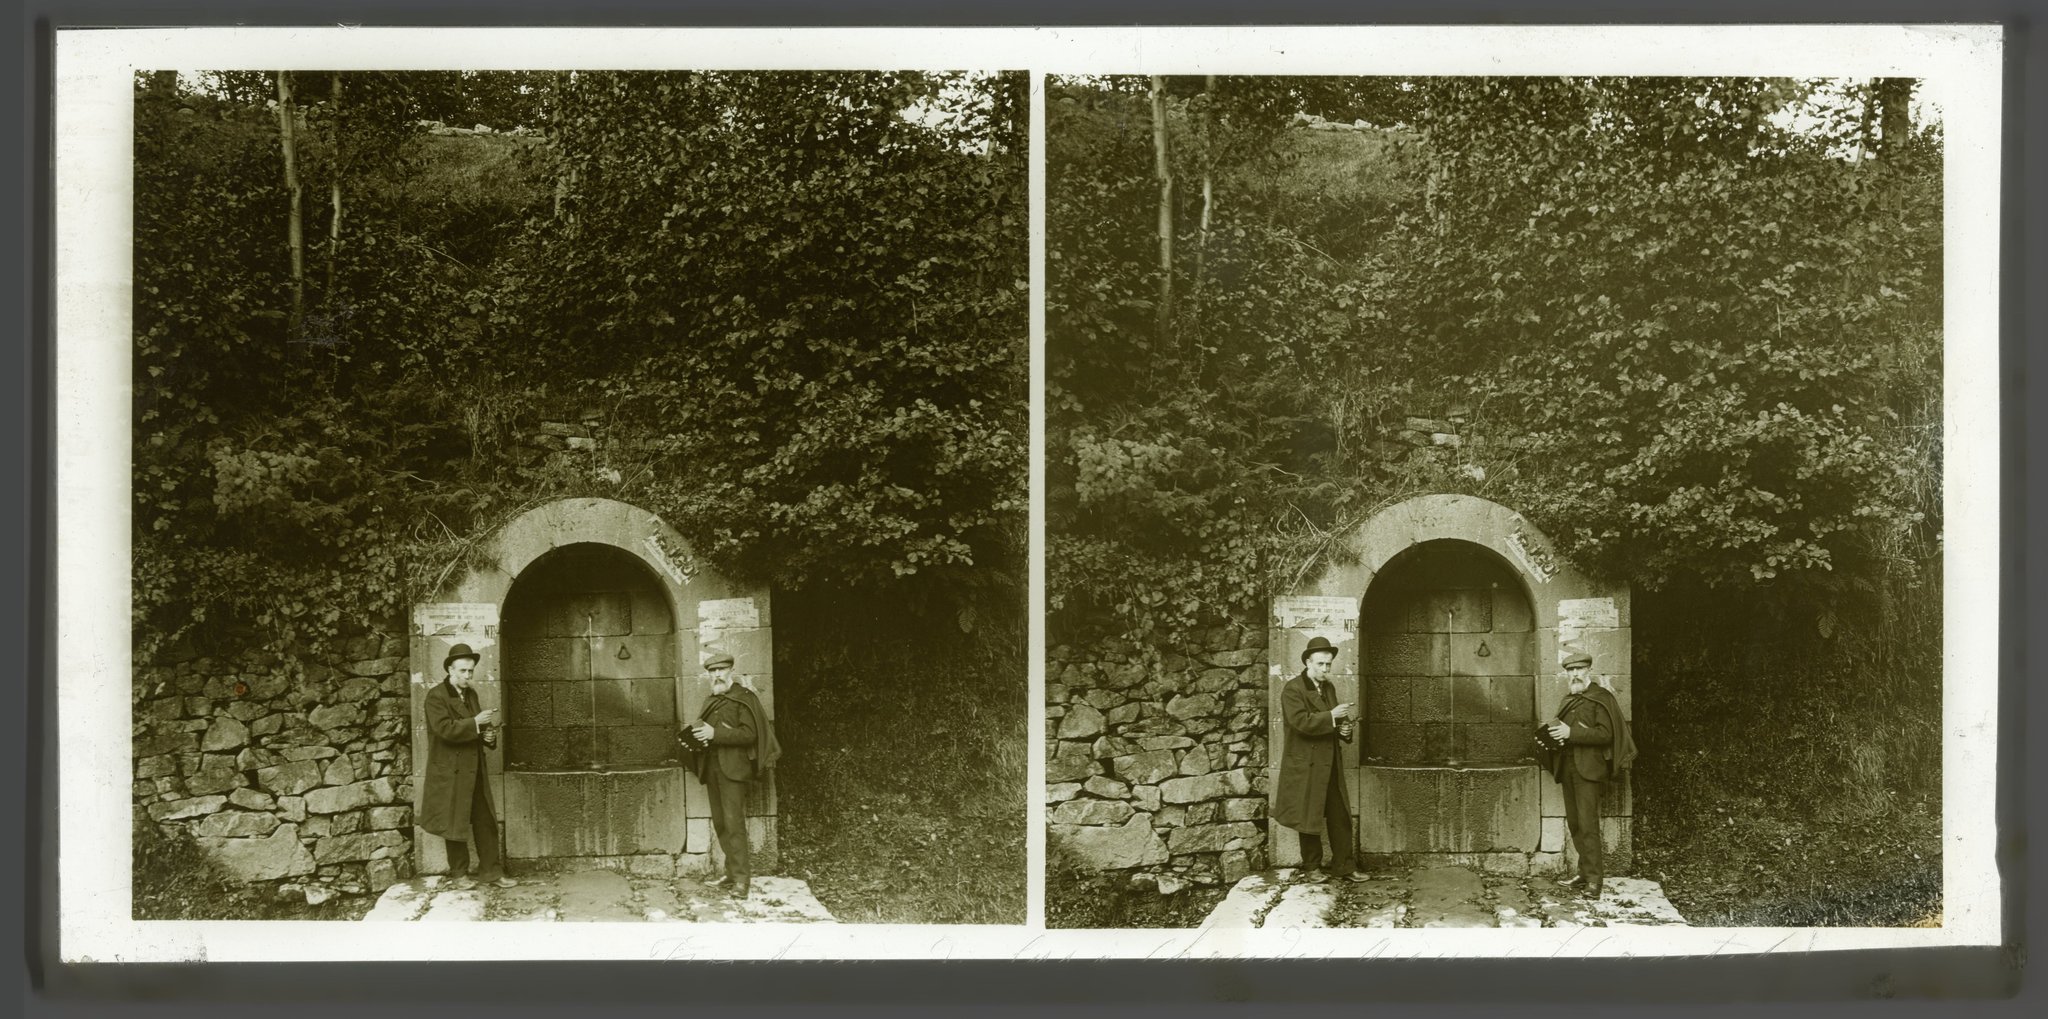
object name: stereoscopic photograph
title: Twee mannen staande voor een fontein in Chaudes-Aigues, Frankrijk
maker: Anonymous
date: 1860-1890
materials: glass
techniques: slide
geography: chaudes-aigues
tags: ornamental fountain (in village)